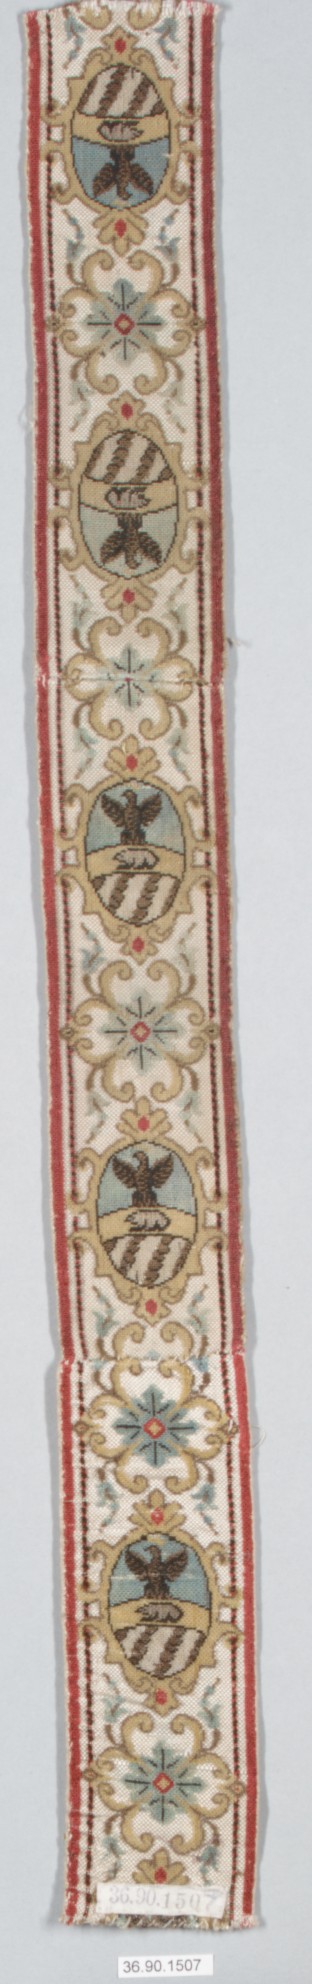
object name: galloon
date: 1701-1900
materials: silk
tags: coat of arms